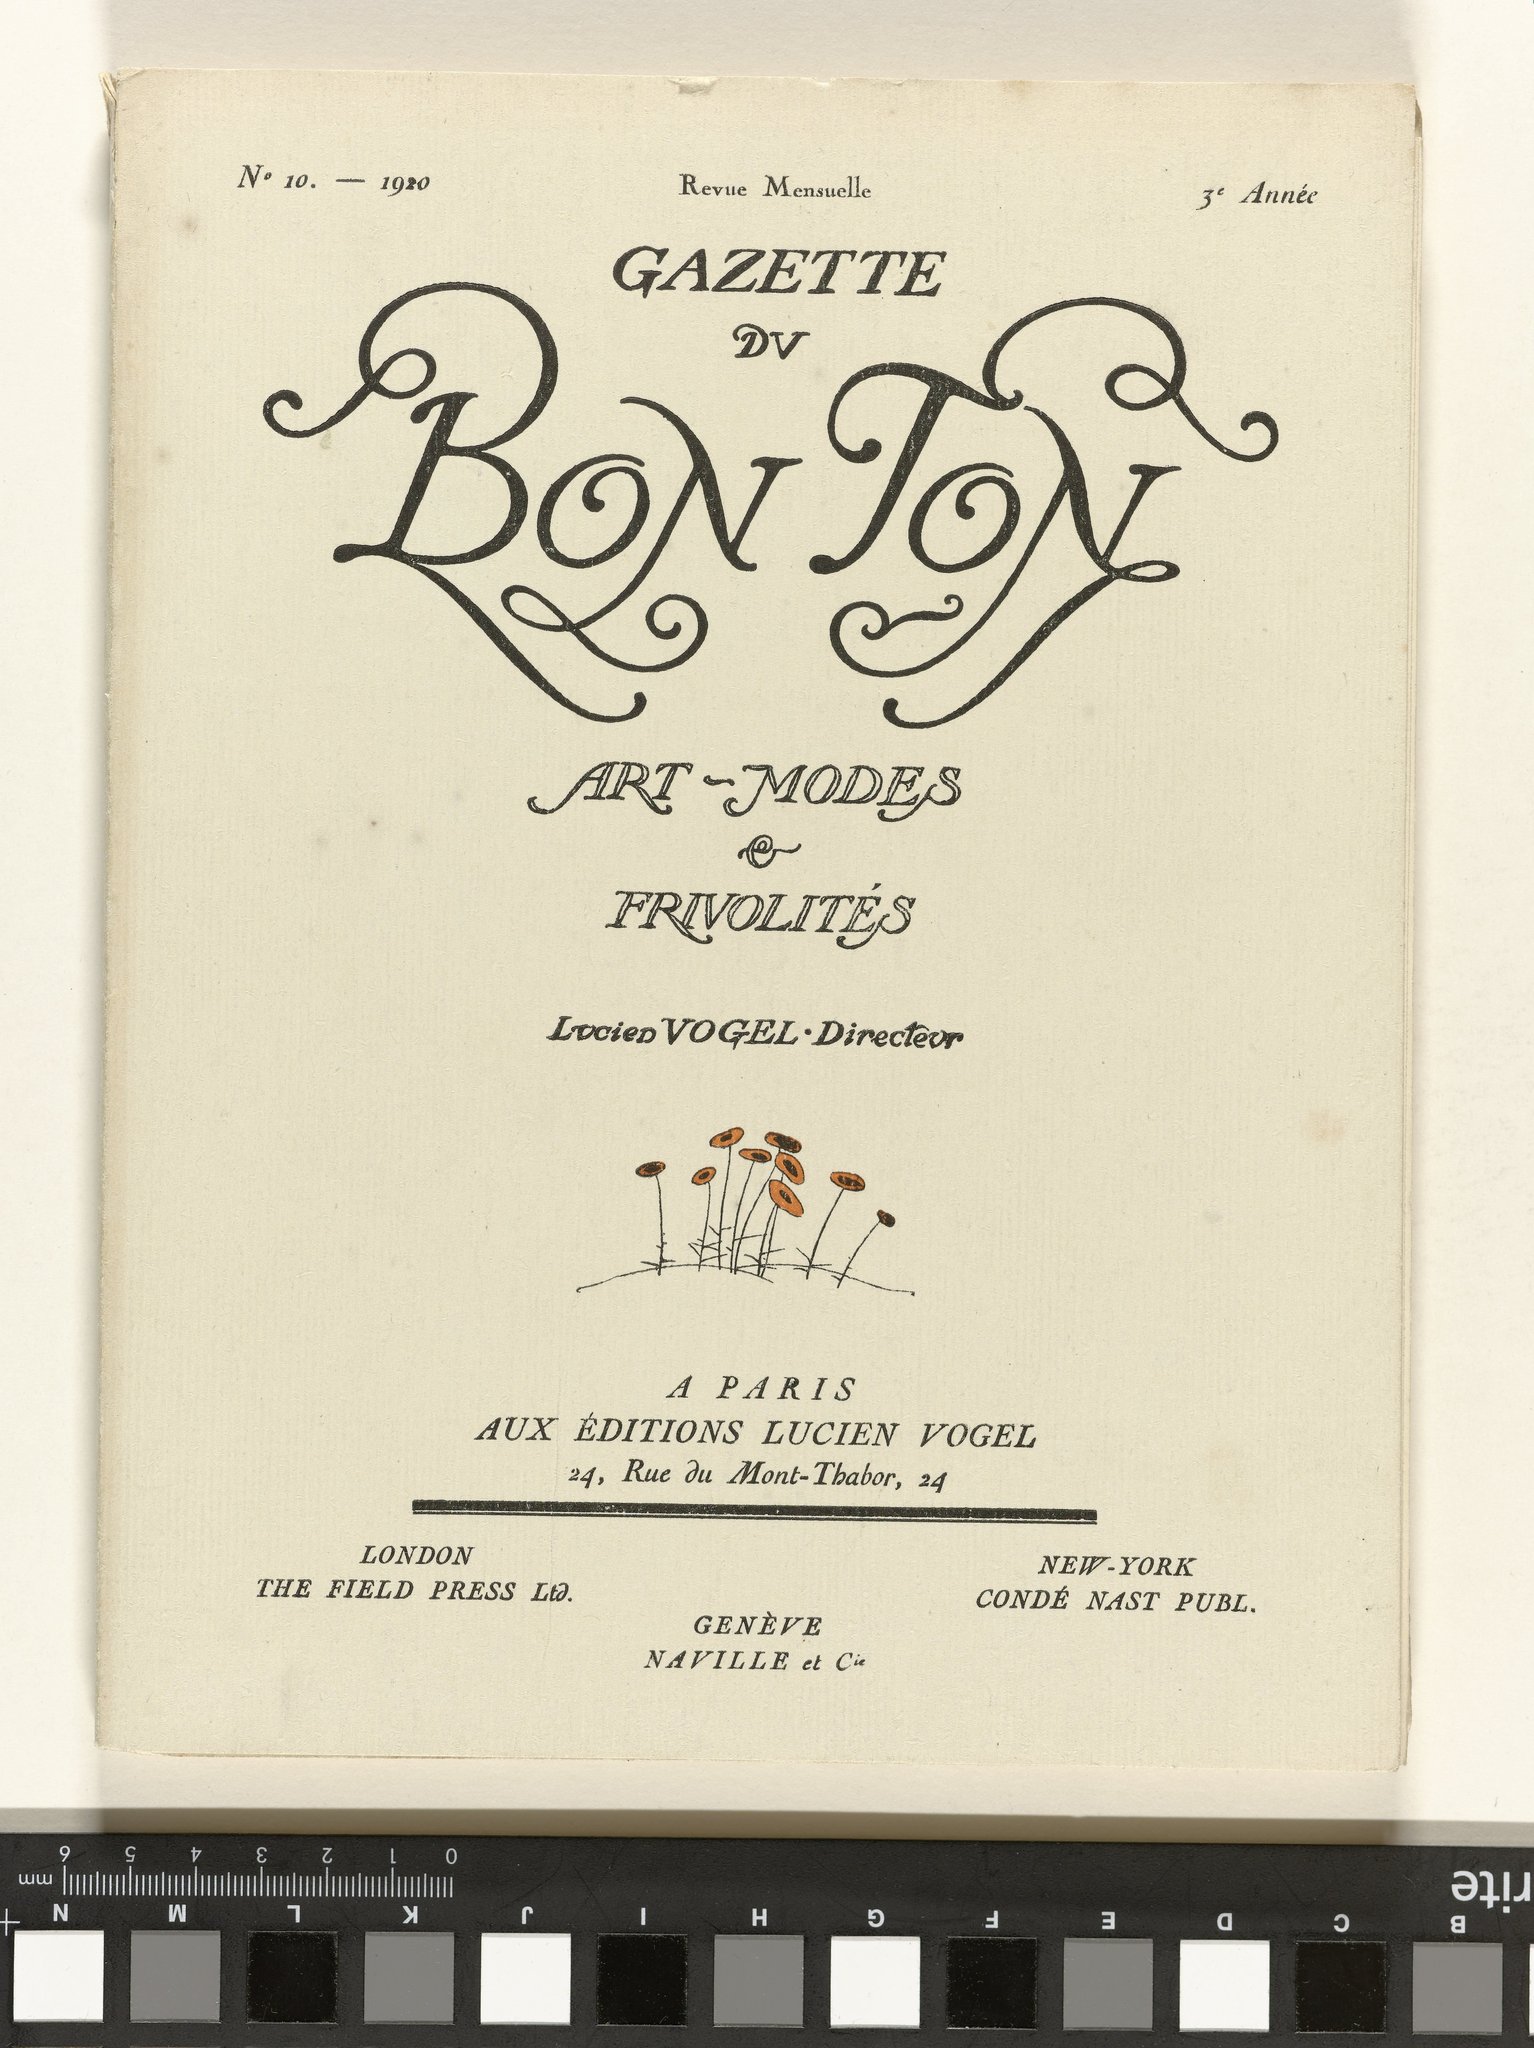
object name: fashion print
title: Gazette du Bon Ton. Art - Modes & Frivolités, 1920, 3e Année, No 10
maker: lucien vogel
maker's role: publisher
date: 1920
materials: paper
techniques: letterpress printing, pochoir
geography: paris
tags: fashion plates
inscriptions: date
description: Aflevering No. 10, december 1920, van Gazette du Bon Ton, bestaand uit een omslag, negen katernen met tekst en illustraties en twaalf losse prenten. Aan dit deel werkten de volgende modeontwerpers mee: Beer, Cheruit, Doeuillet, Doucet, Lanvin, Paquin, Paul Poiret, Redfern en Worth.